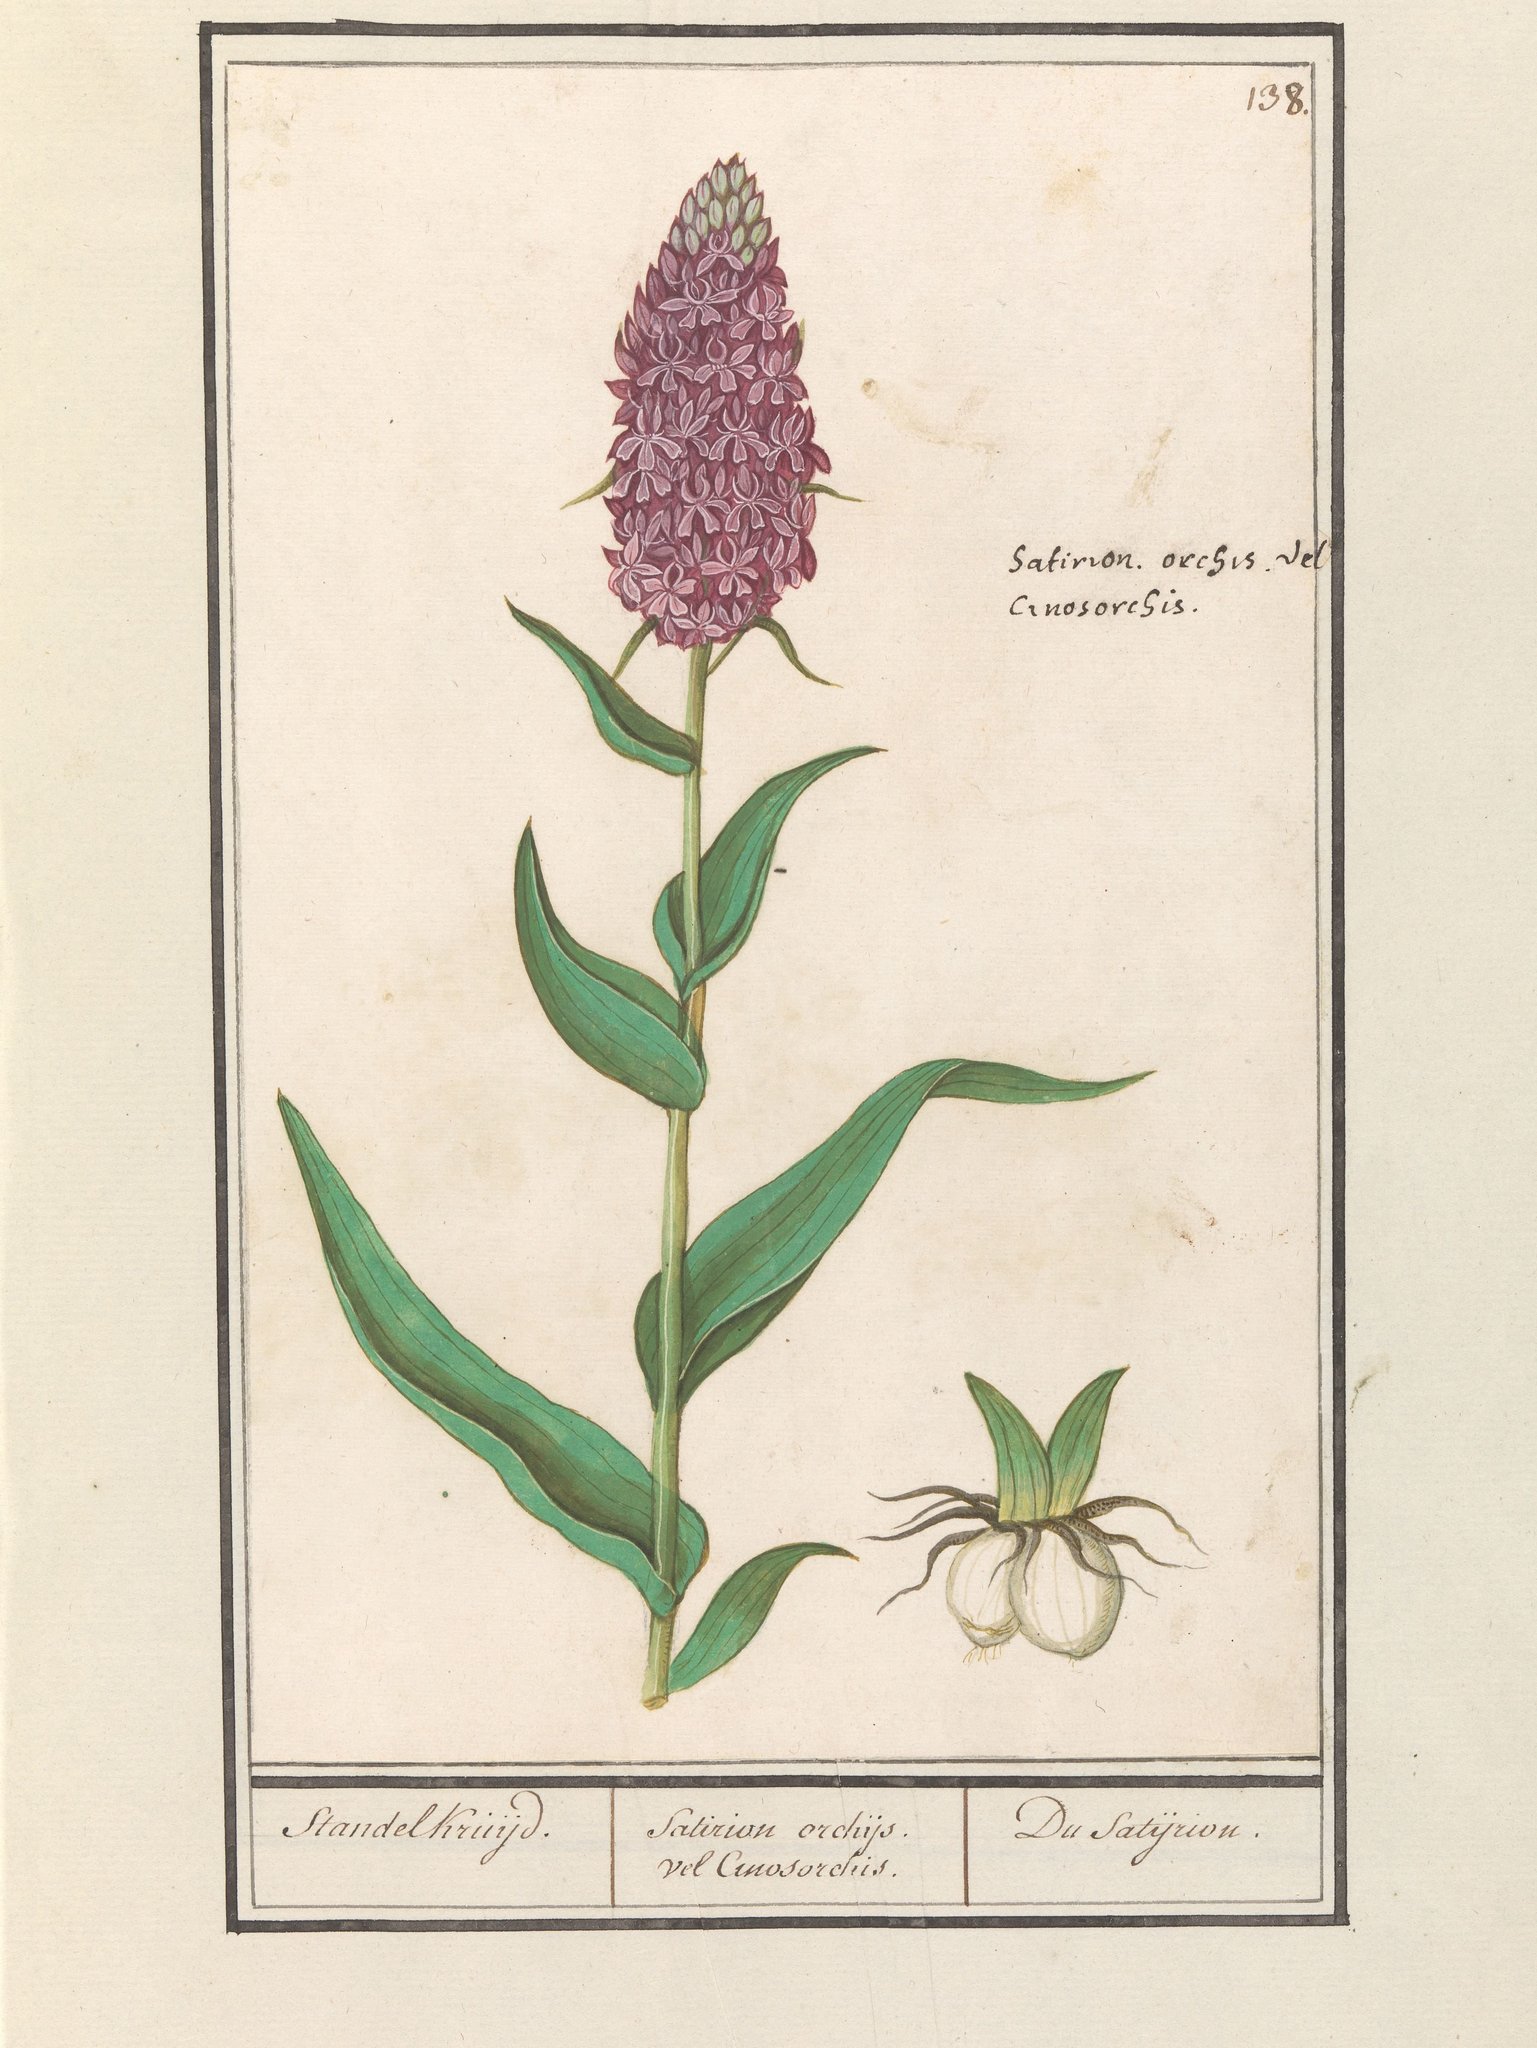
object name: drawing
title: Brede orchis (Dactylorhiza majalis)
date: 1596-1610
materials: chalk, paint, ink, paper, watercolor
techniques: brush, pen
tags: flowers: orchid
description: Orchidee, waarschijnlijk de brede orchis. Rechtsboven genummerd: 138. Rechtsboven de Latijnse naam. Onderdeel van het tweede album met tekeningen van bloemen en planten. Negende van twaalf albums met tekeningen van dieren, vogels en planten bekend rond 1600, gemaakt in opdracht van keizer Rudolf II. Met toelichting in Nederlands, Latijn en Frans.